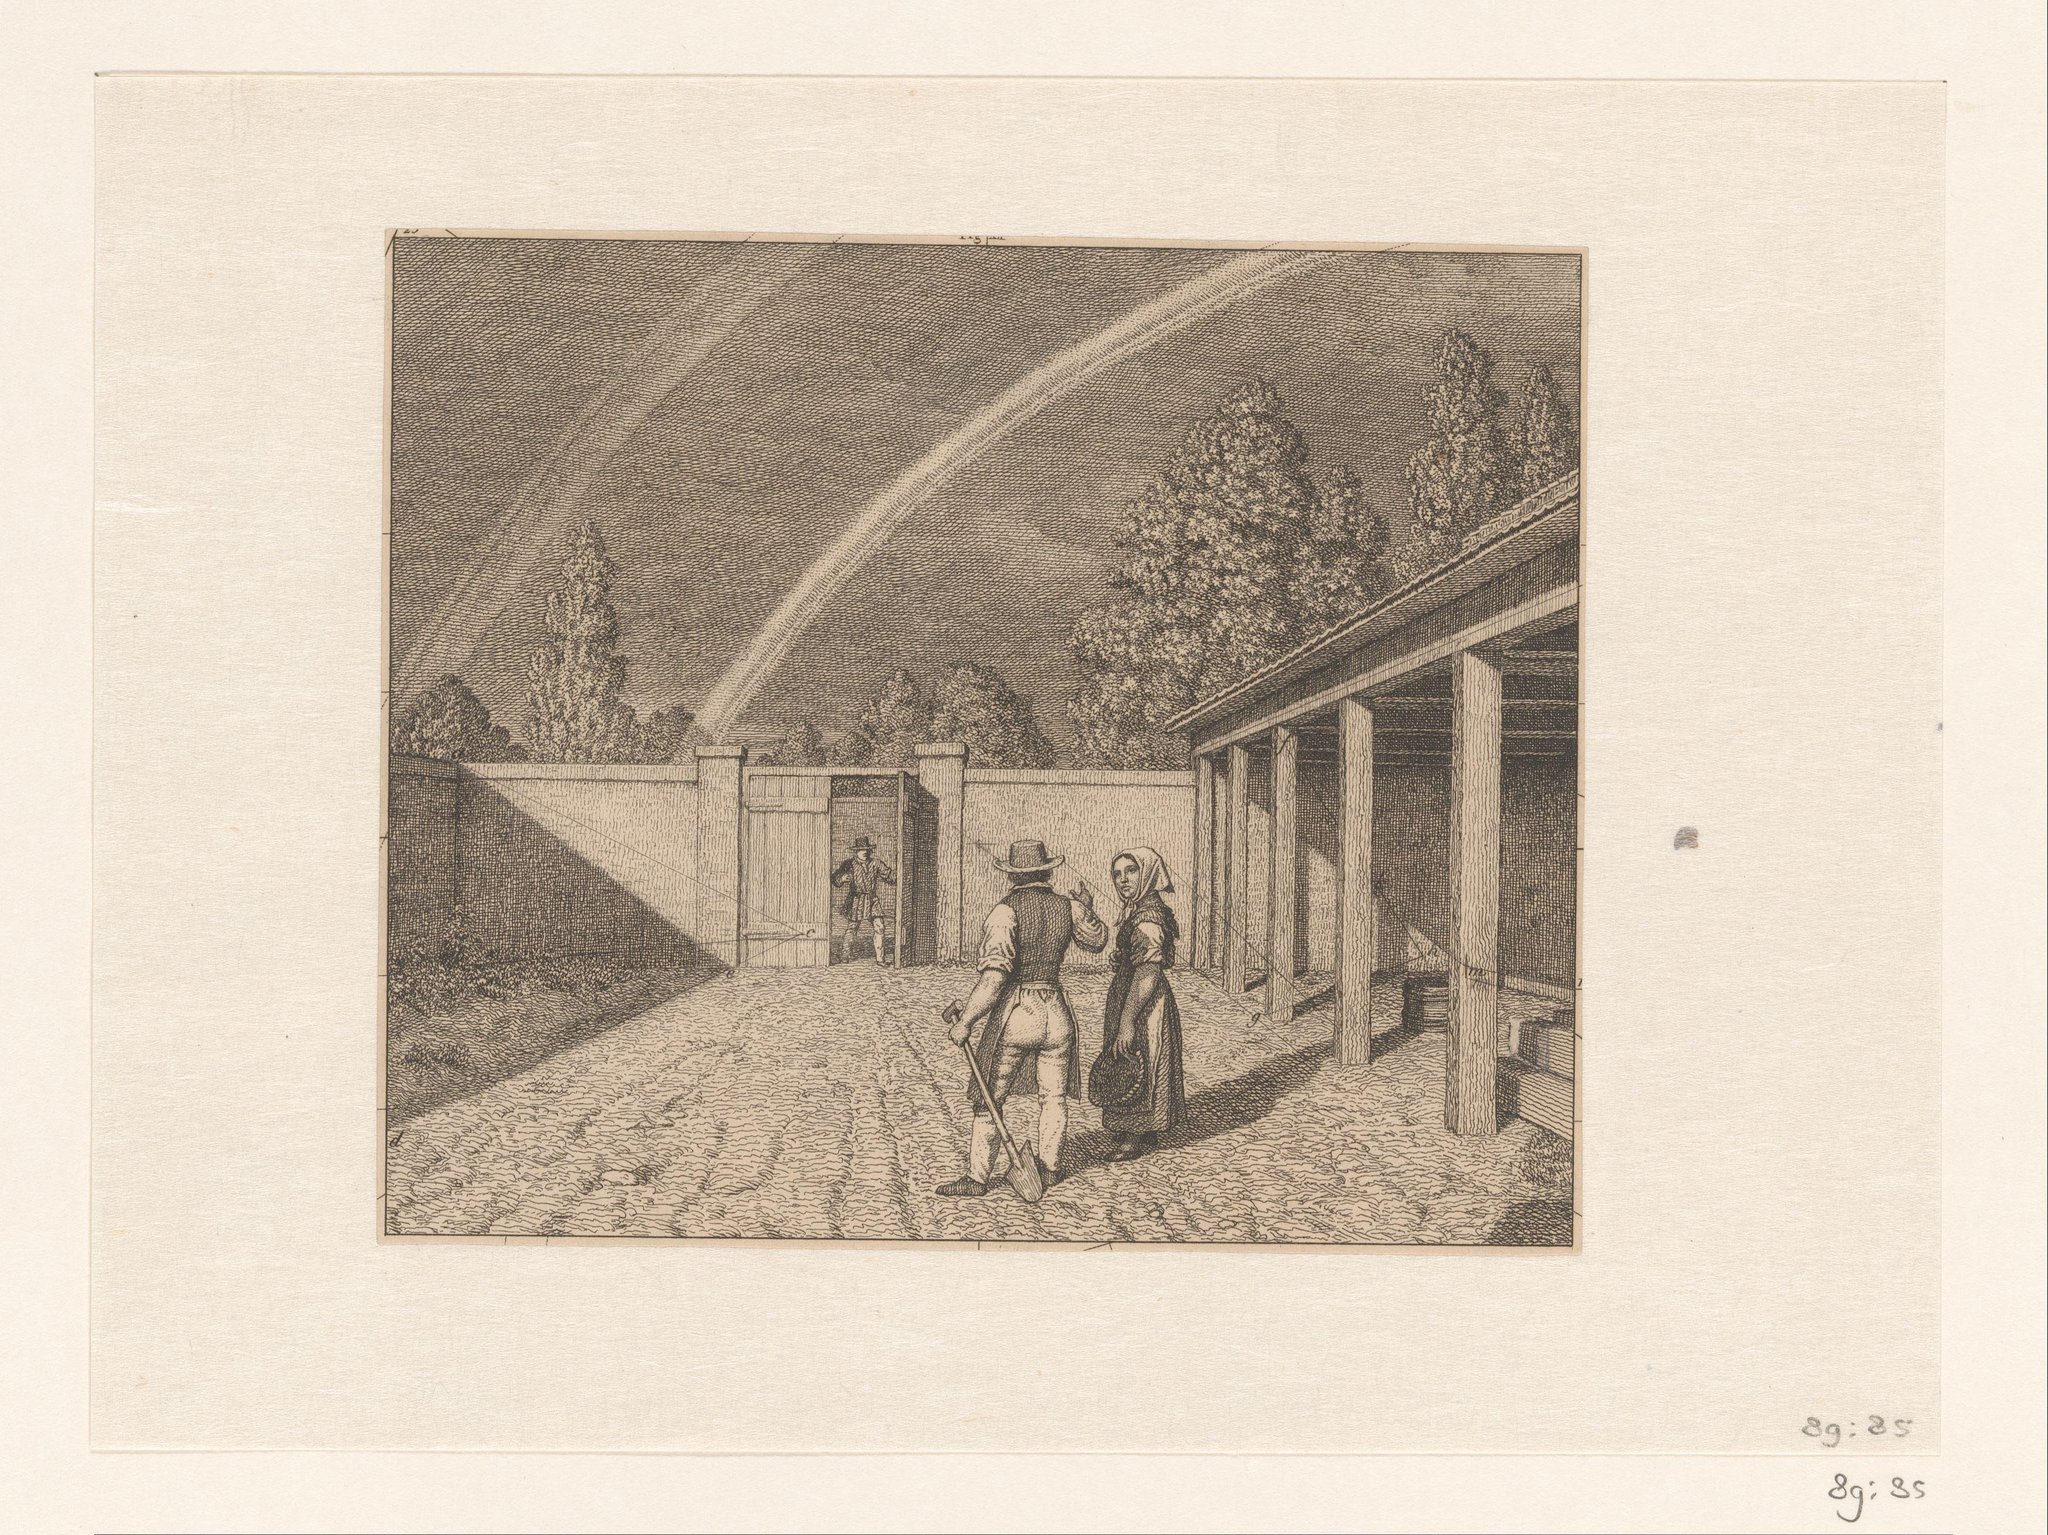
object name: print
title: Linear Perspective used in painting art, gepubliceerde versie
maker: christoffer wilhelm eckersberg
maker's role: painter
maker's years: 1783-1853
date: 1841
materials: paper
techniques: etching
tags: mathematical perspective, rainbow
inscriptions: collector's mark: Lugt 2228, collector's mark: Lugt 2760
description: Gezicht op een binnenplaats met enkele figuren. Dubbele regenboog in de lucht. Perspectiefstudie, staat voor de huplijnen.